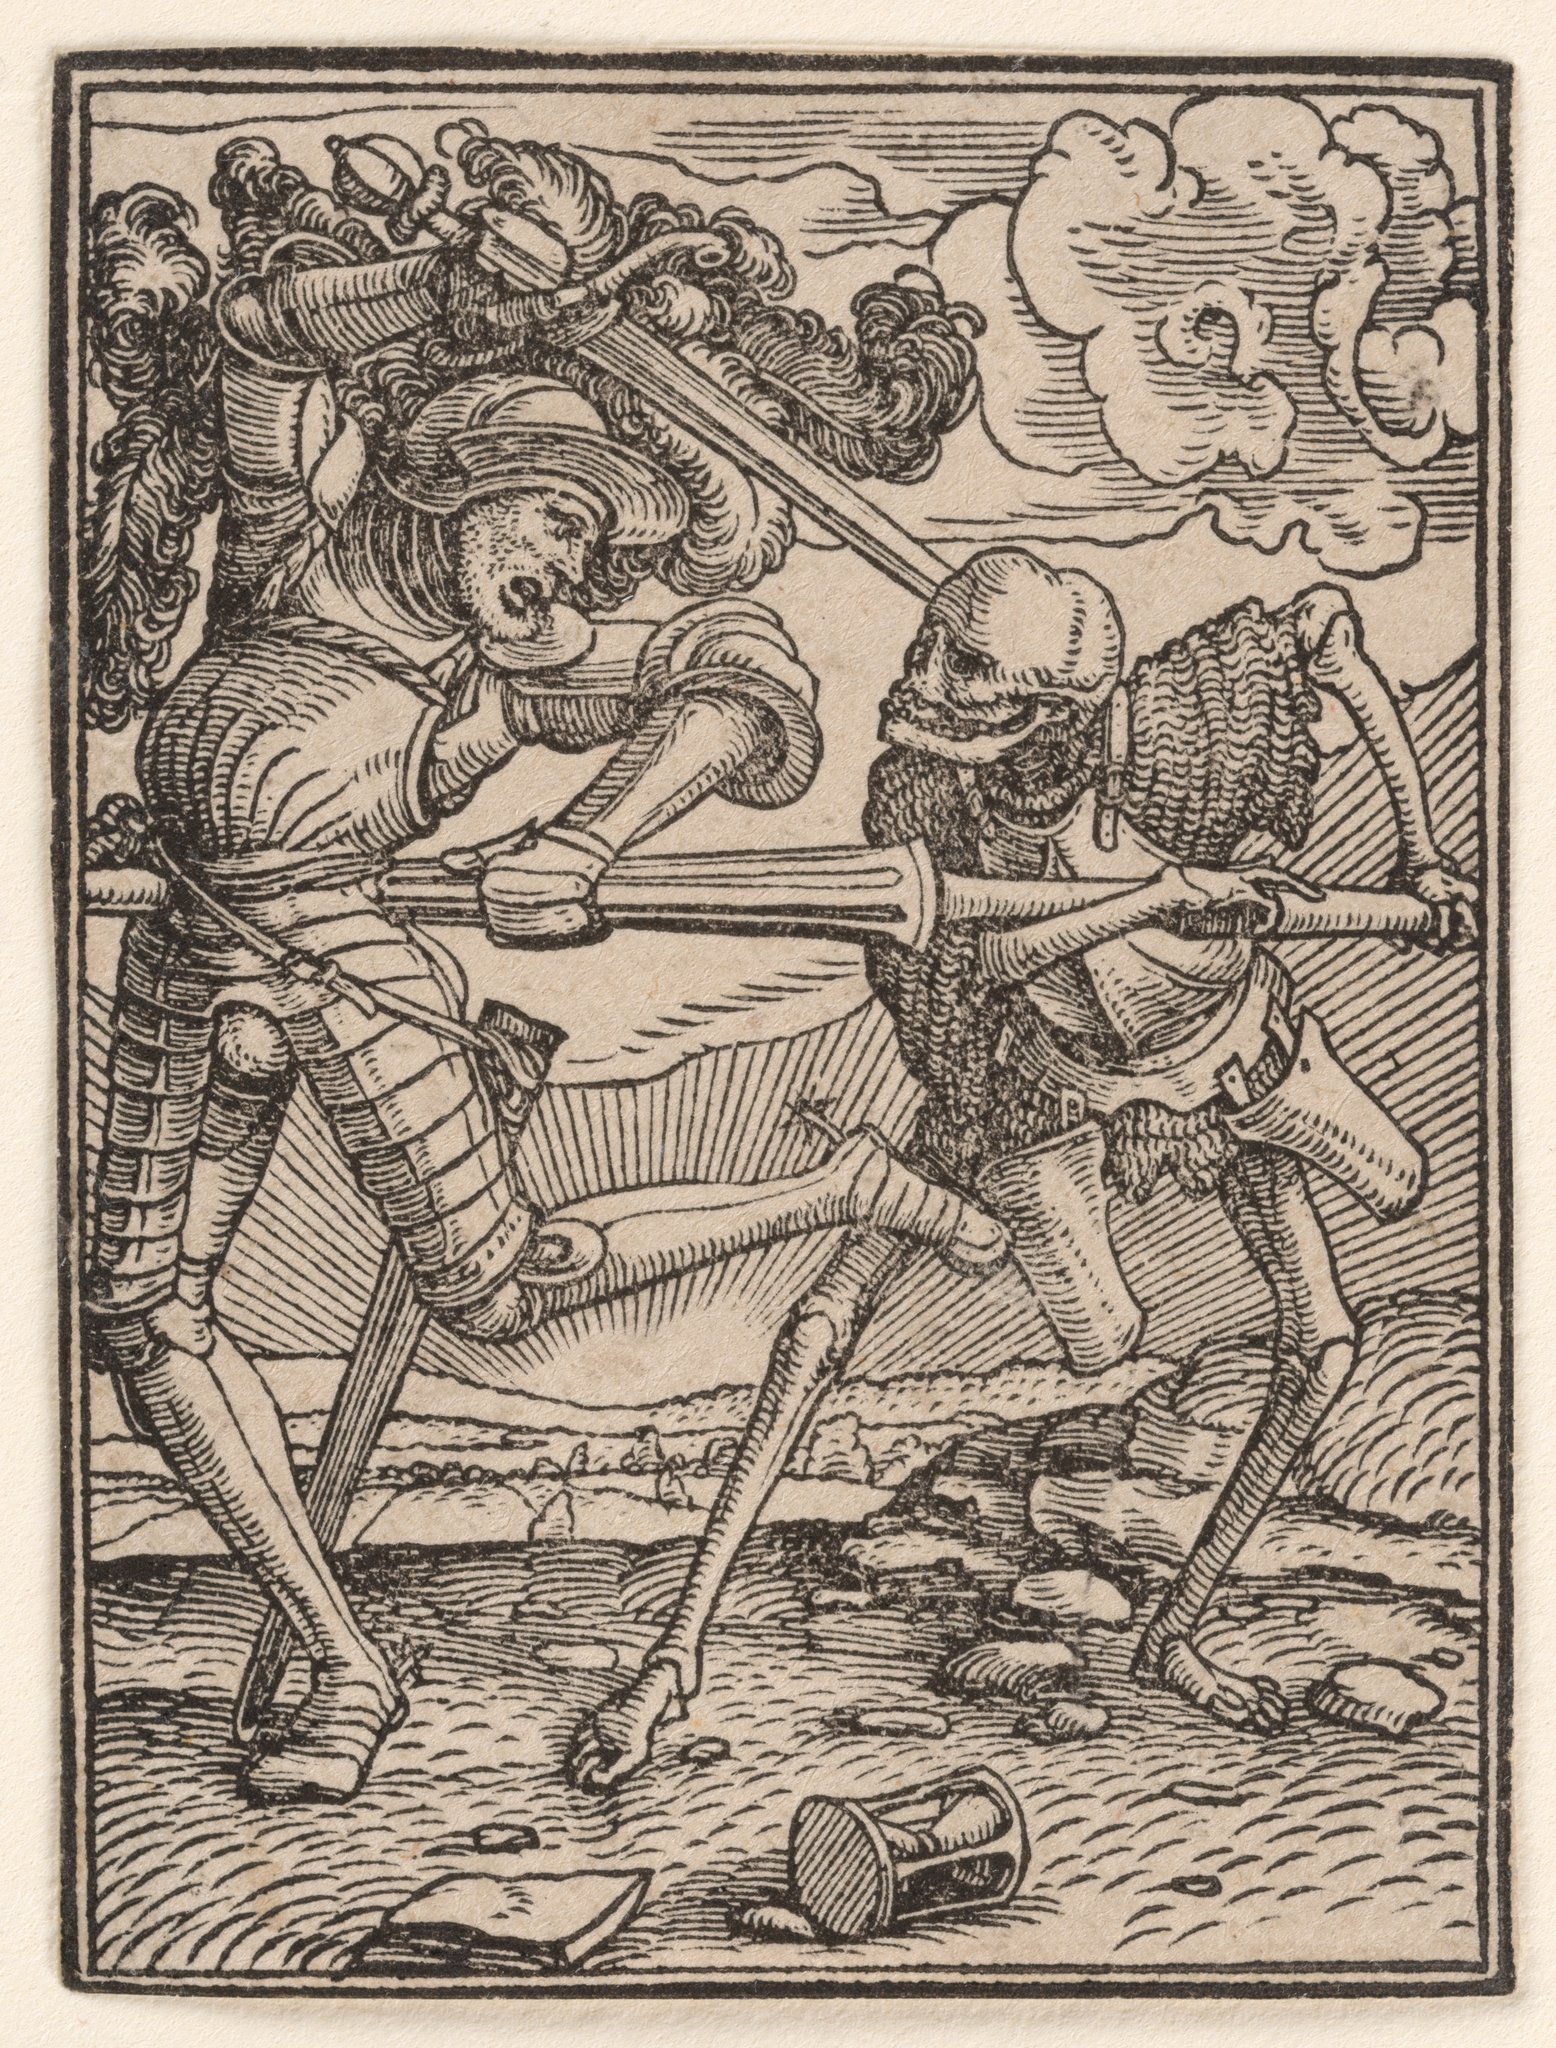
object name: print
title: The Knight, from "The Dance of Death"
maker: hans holbein the younger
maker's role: artist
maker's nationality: german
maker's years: 1497-1543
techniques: woodcut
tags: swords,skeletons,men,knights